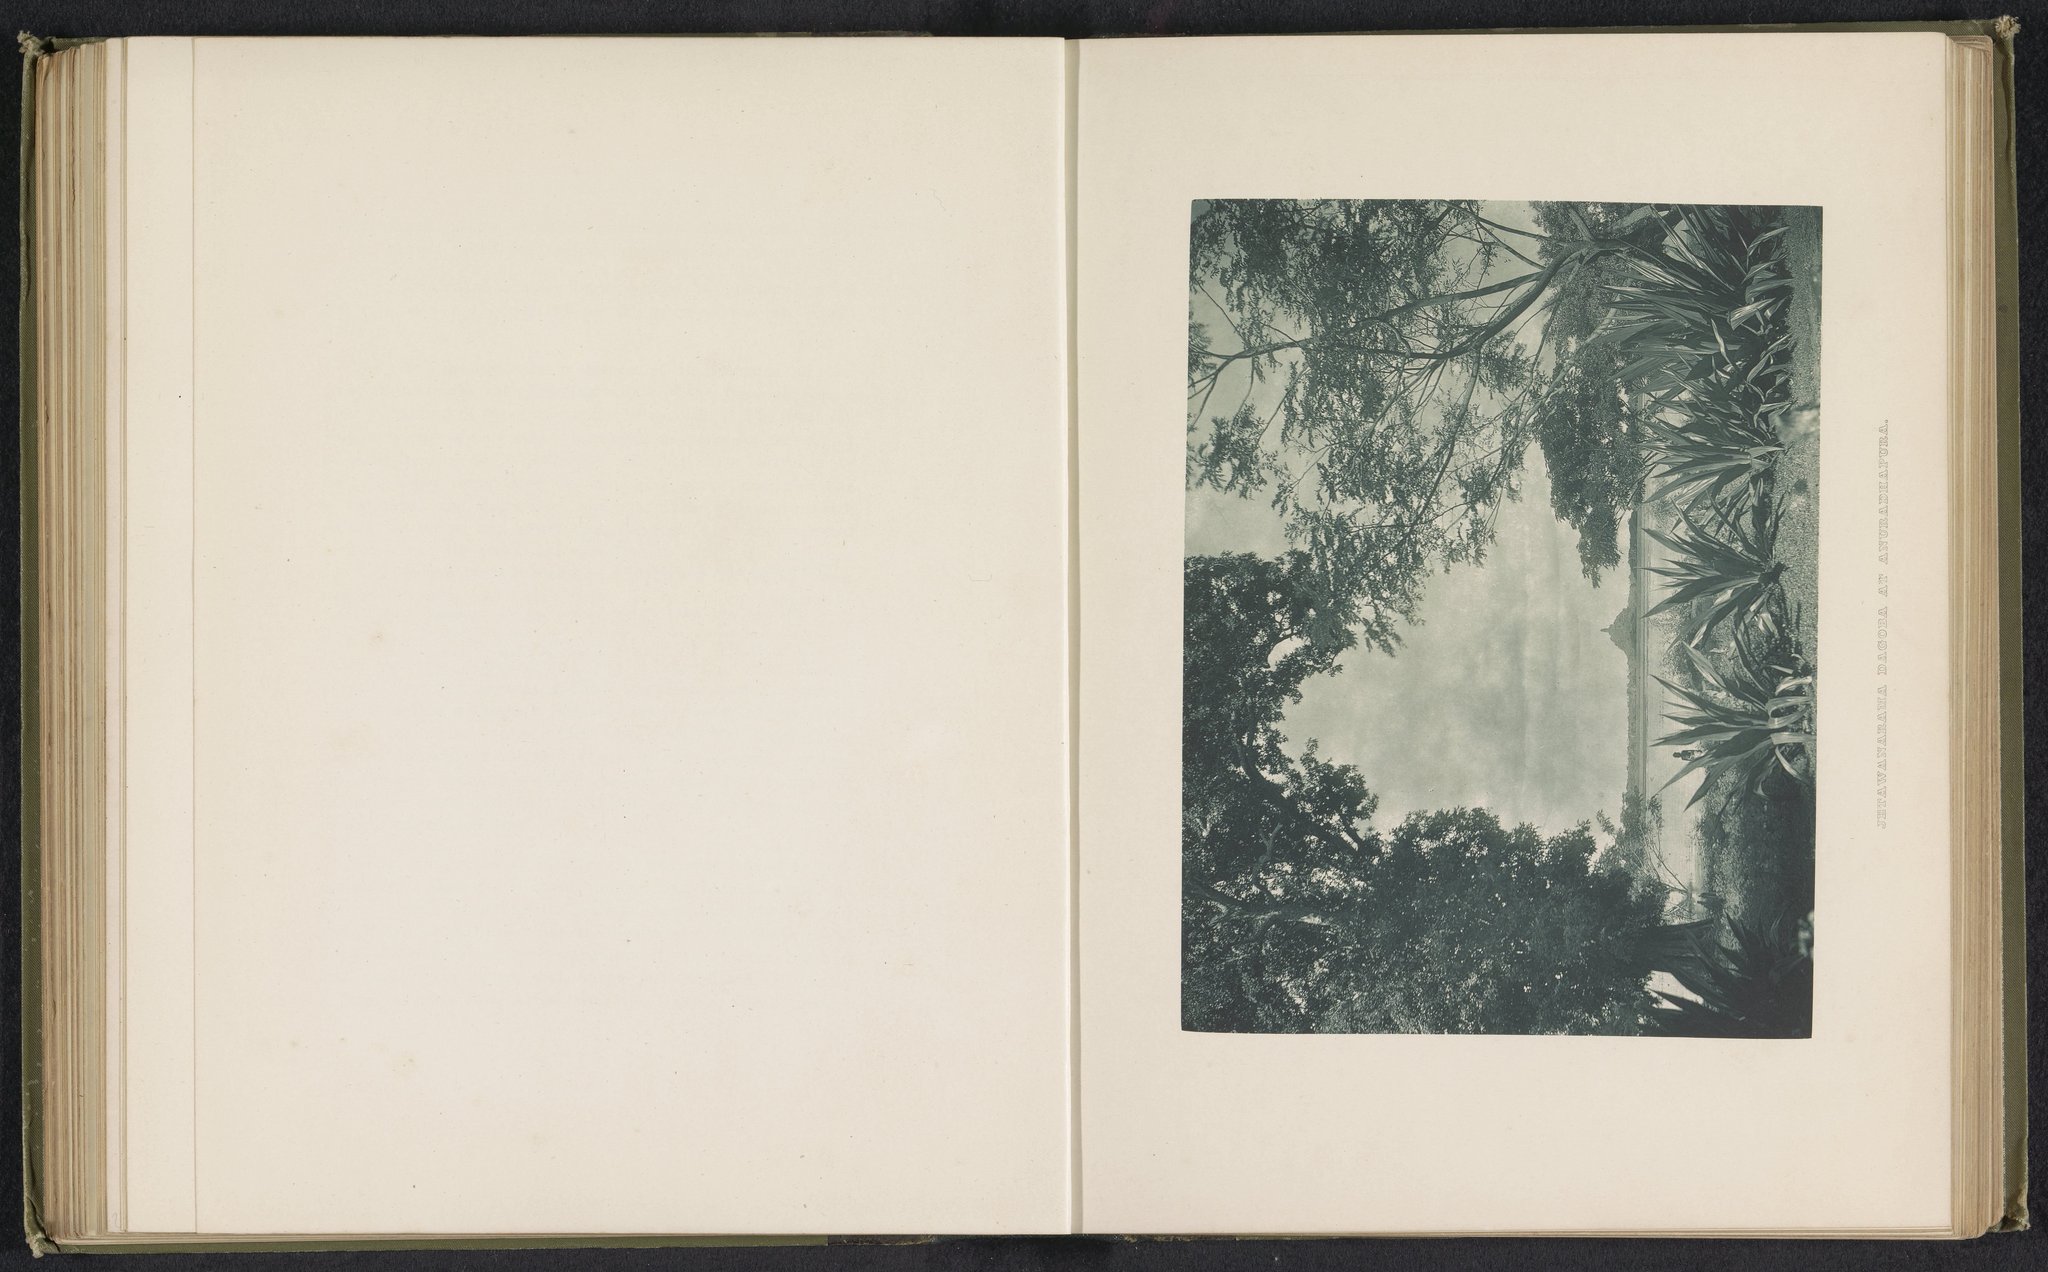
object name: page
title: View of the Jetavanaramaya stupa at Anuradhapura, Sri Lanka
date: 1896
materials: paper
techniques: woodburygravure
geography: anuradhapura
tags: temple, shrine ~ hinduism, buddhism, jainism, landscape with ruins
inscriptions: title: ‘JETAWANARAMA DAGOBA AT ANURADHAPURA.’